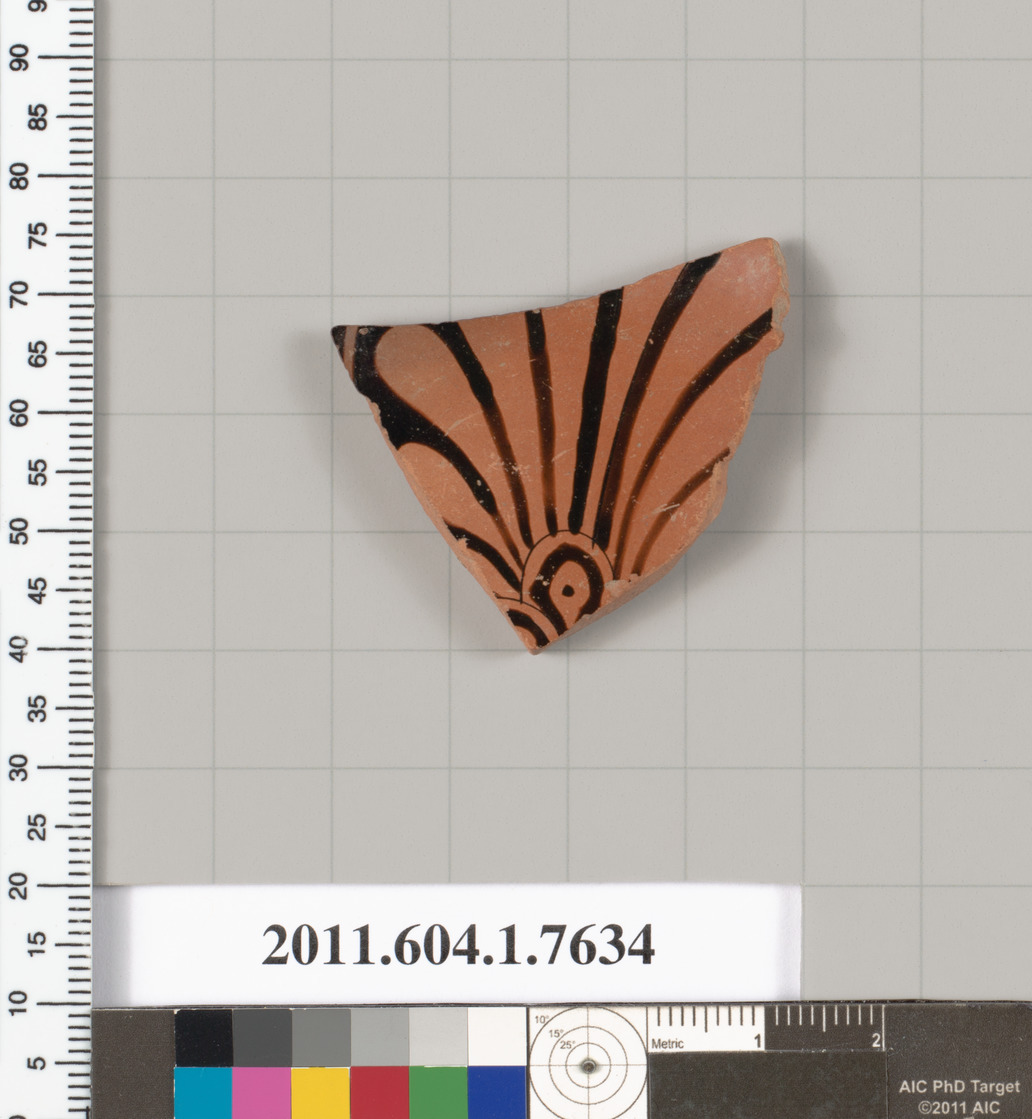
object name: kylix fragment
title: Terracotta fragment of a kylix (drinking cup)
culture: greek, attic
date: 460-450 BCE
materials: terracotta